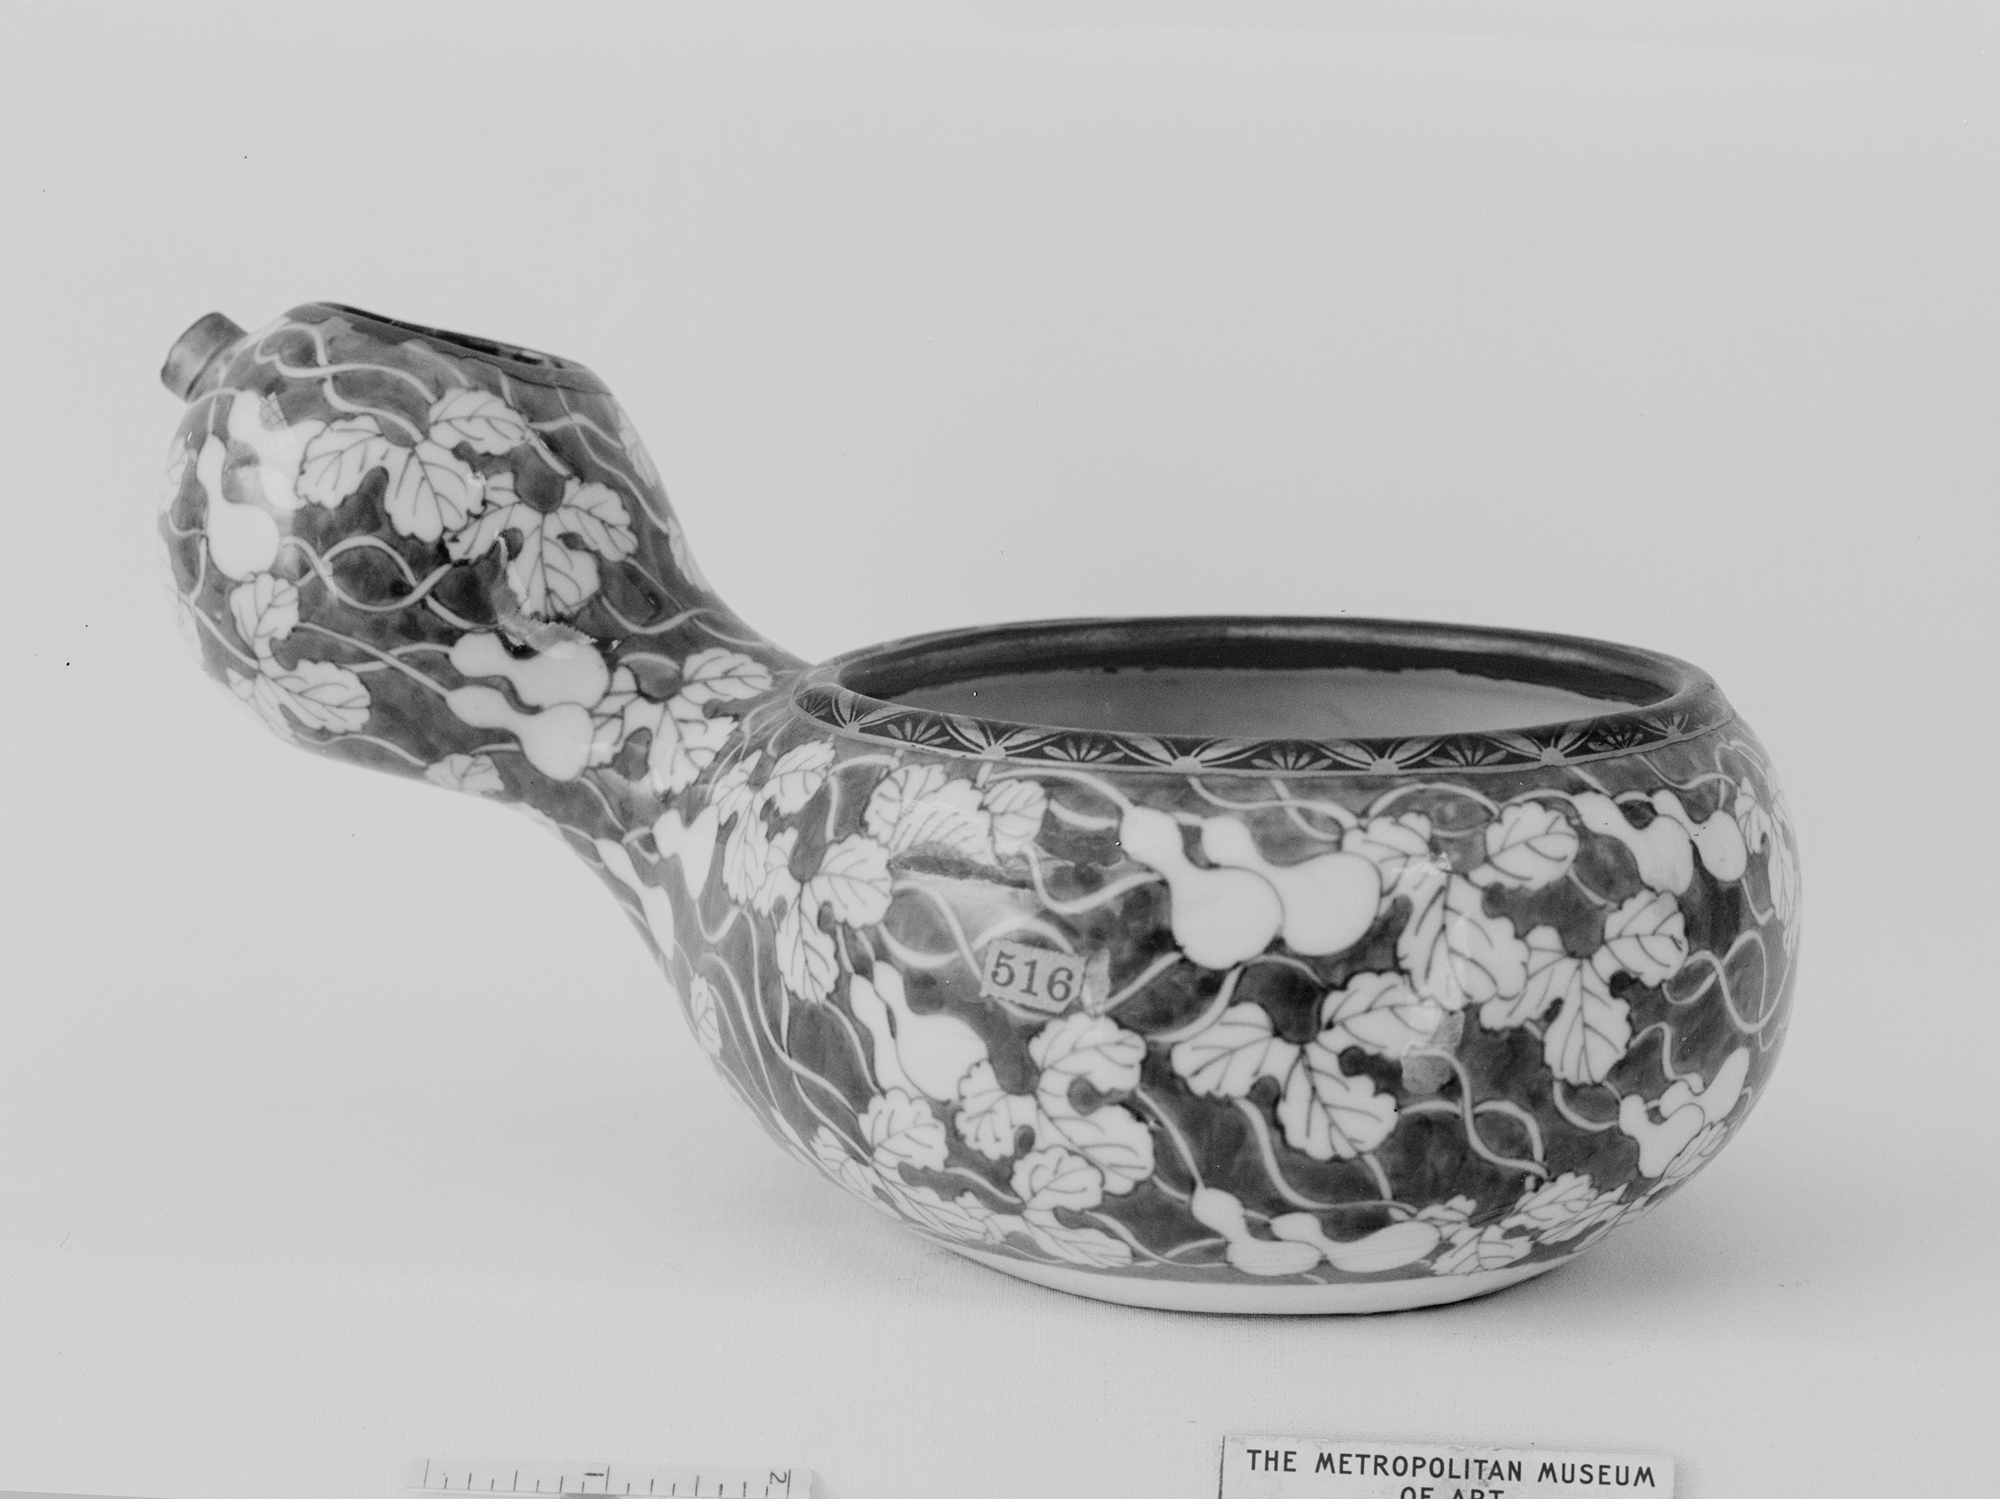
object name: pan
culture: japanese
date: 1701-1800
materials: glaze, lacquer, porcelain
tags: gourds